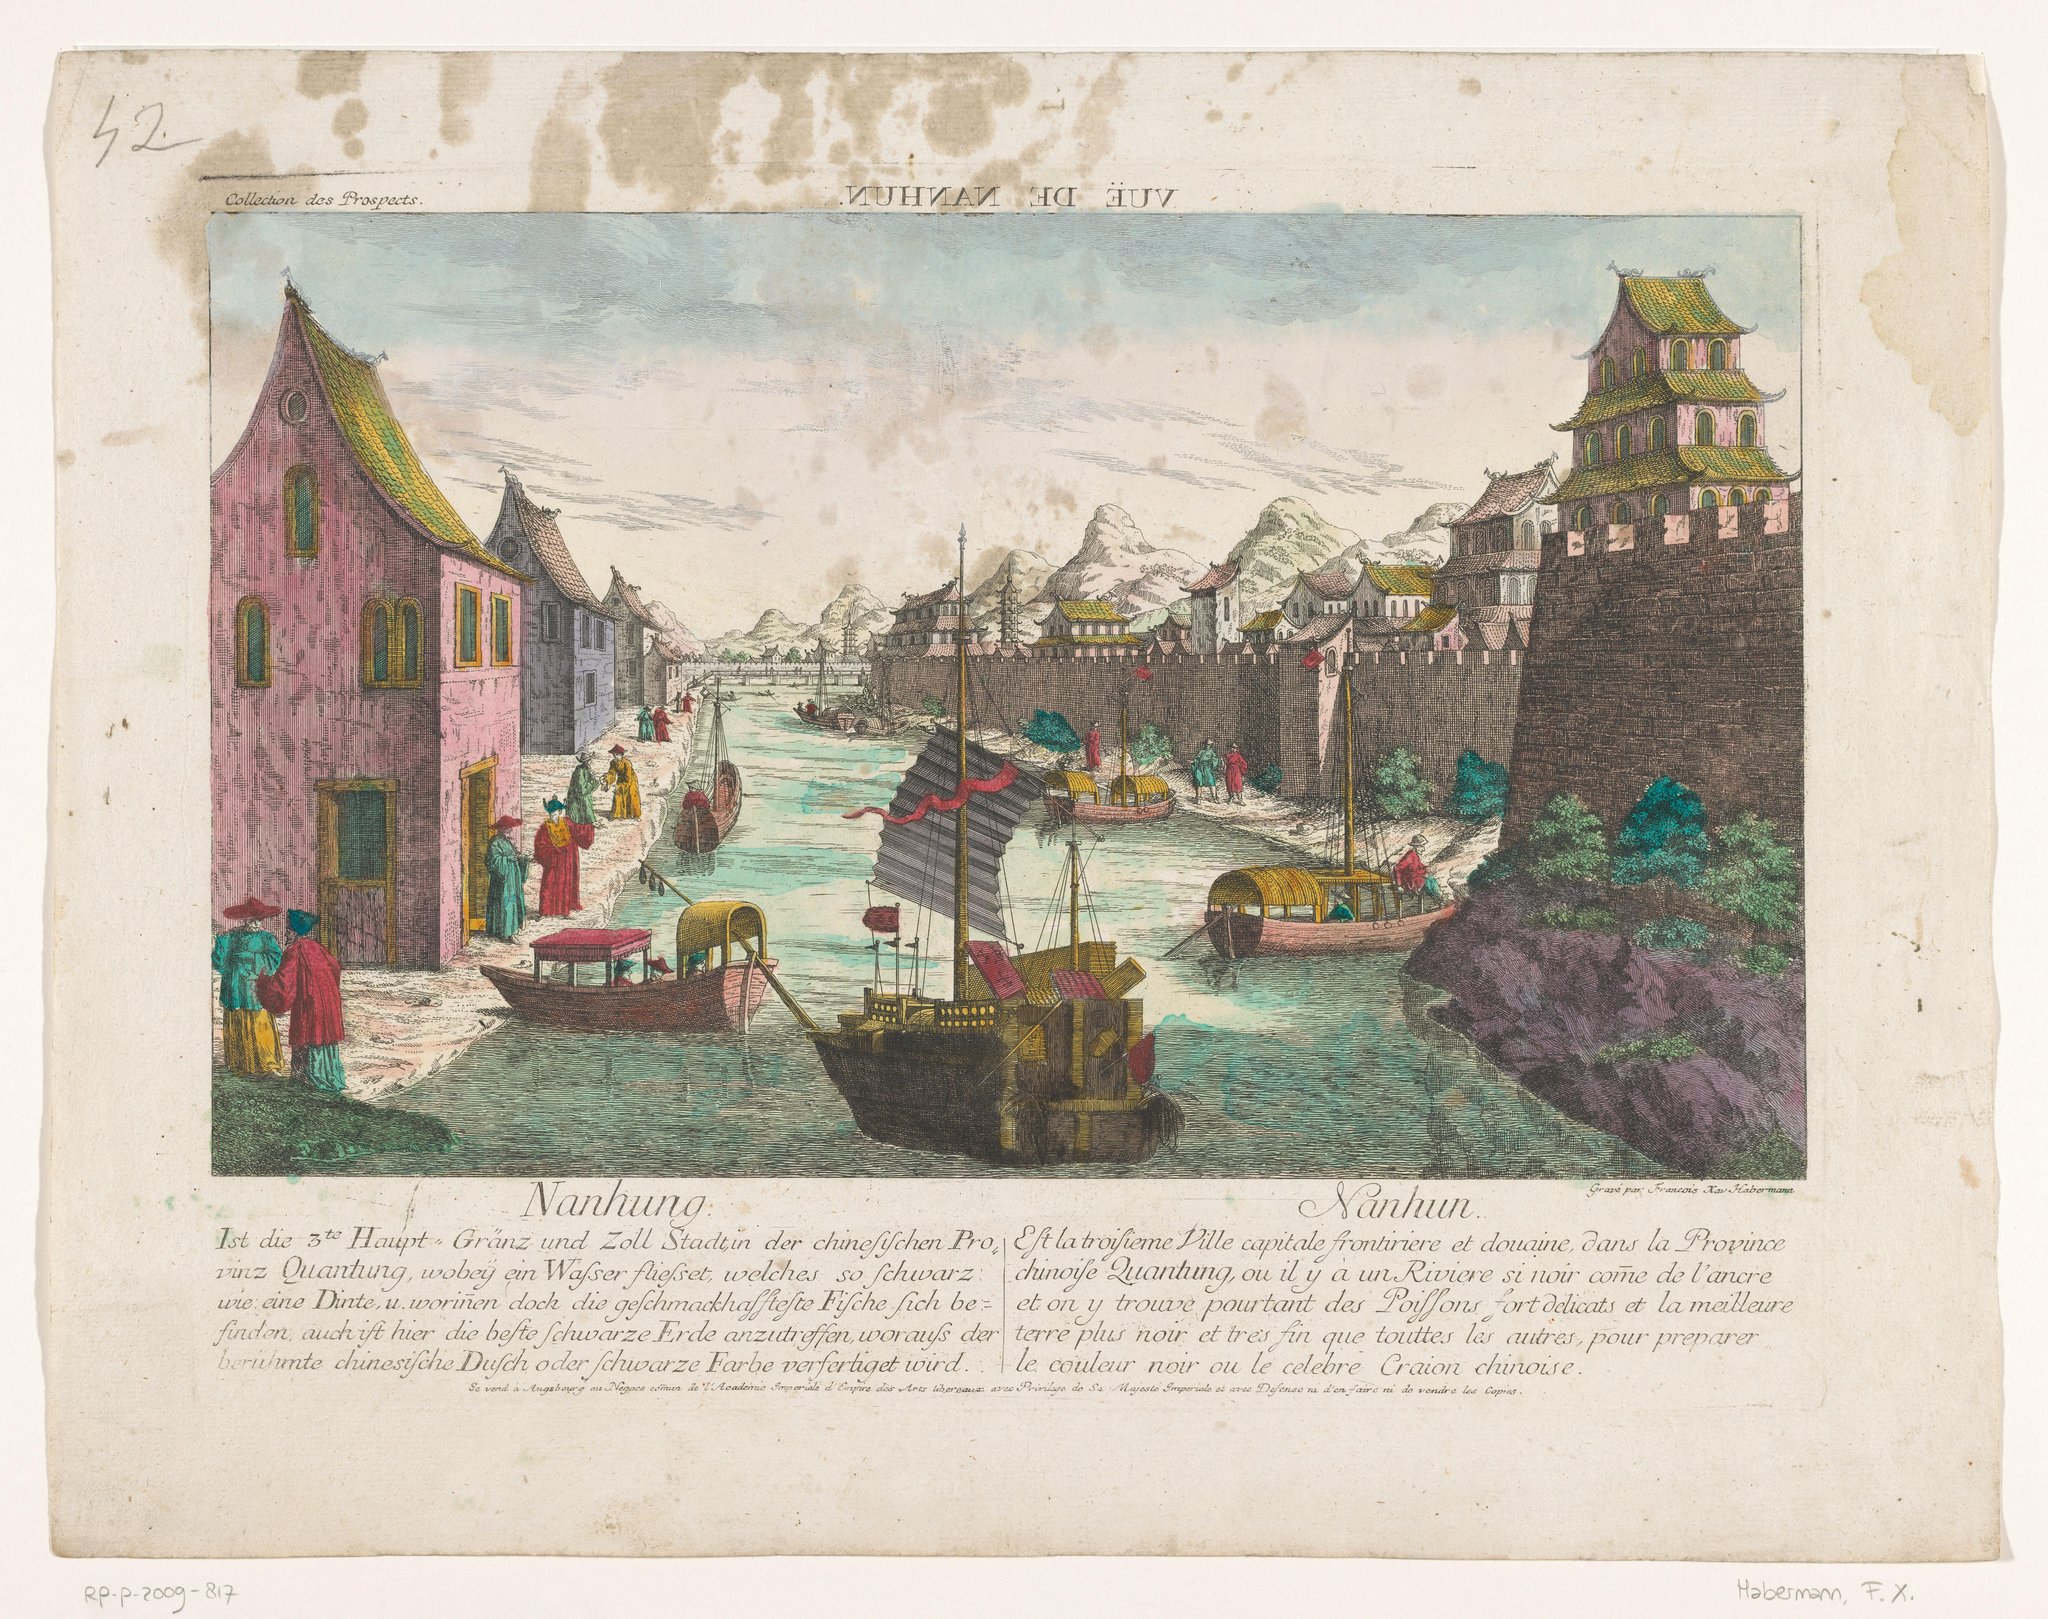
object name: print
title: Nanhung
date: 1755-1779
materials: paper, watercolor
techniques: brush, etching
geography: augsburg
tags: china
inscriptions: collector's mark: Lugt 2228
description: Gezicht op een rivier met aangemeerde schepen en een zeilend schip. Op de linkeroever vrijstaande gebouwen, op de rechter oever een hoge stadsmuur waarachter gebouwen te zien zijn, daarachter bergen. Langs het water figuren. Onder de prent een beschrijving in het Duits en het Frans.